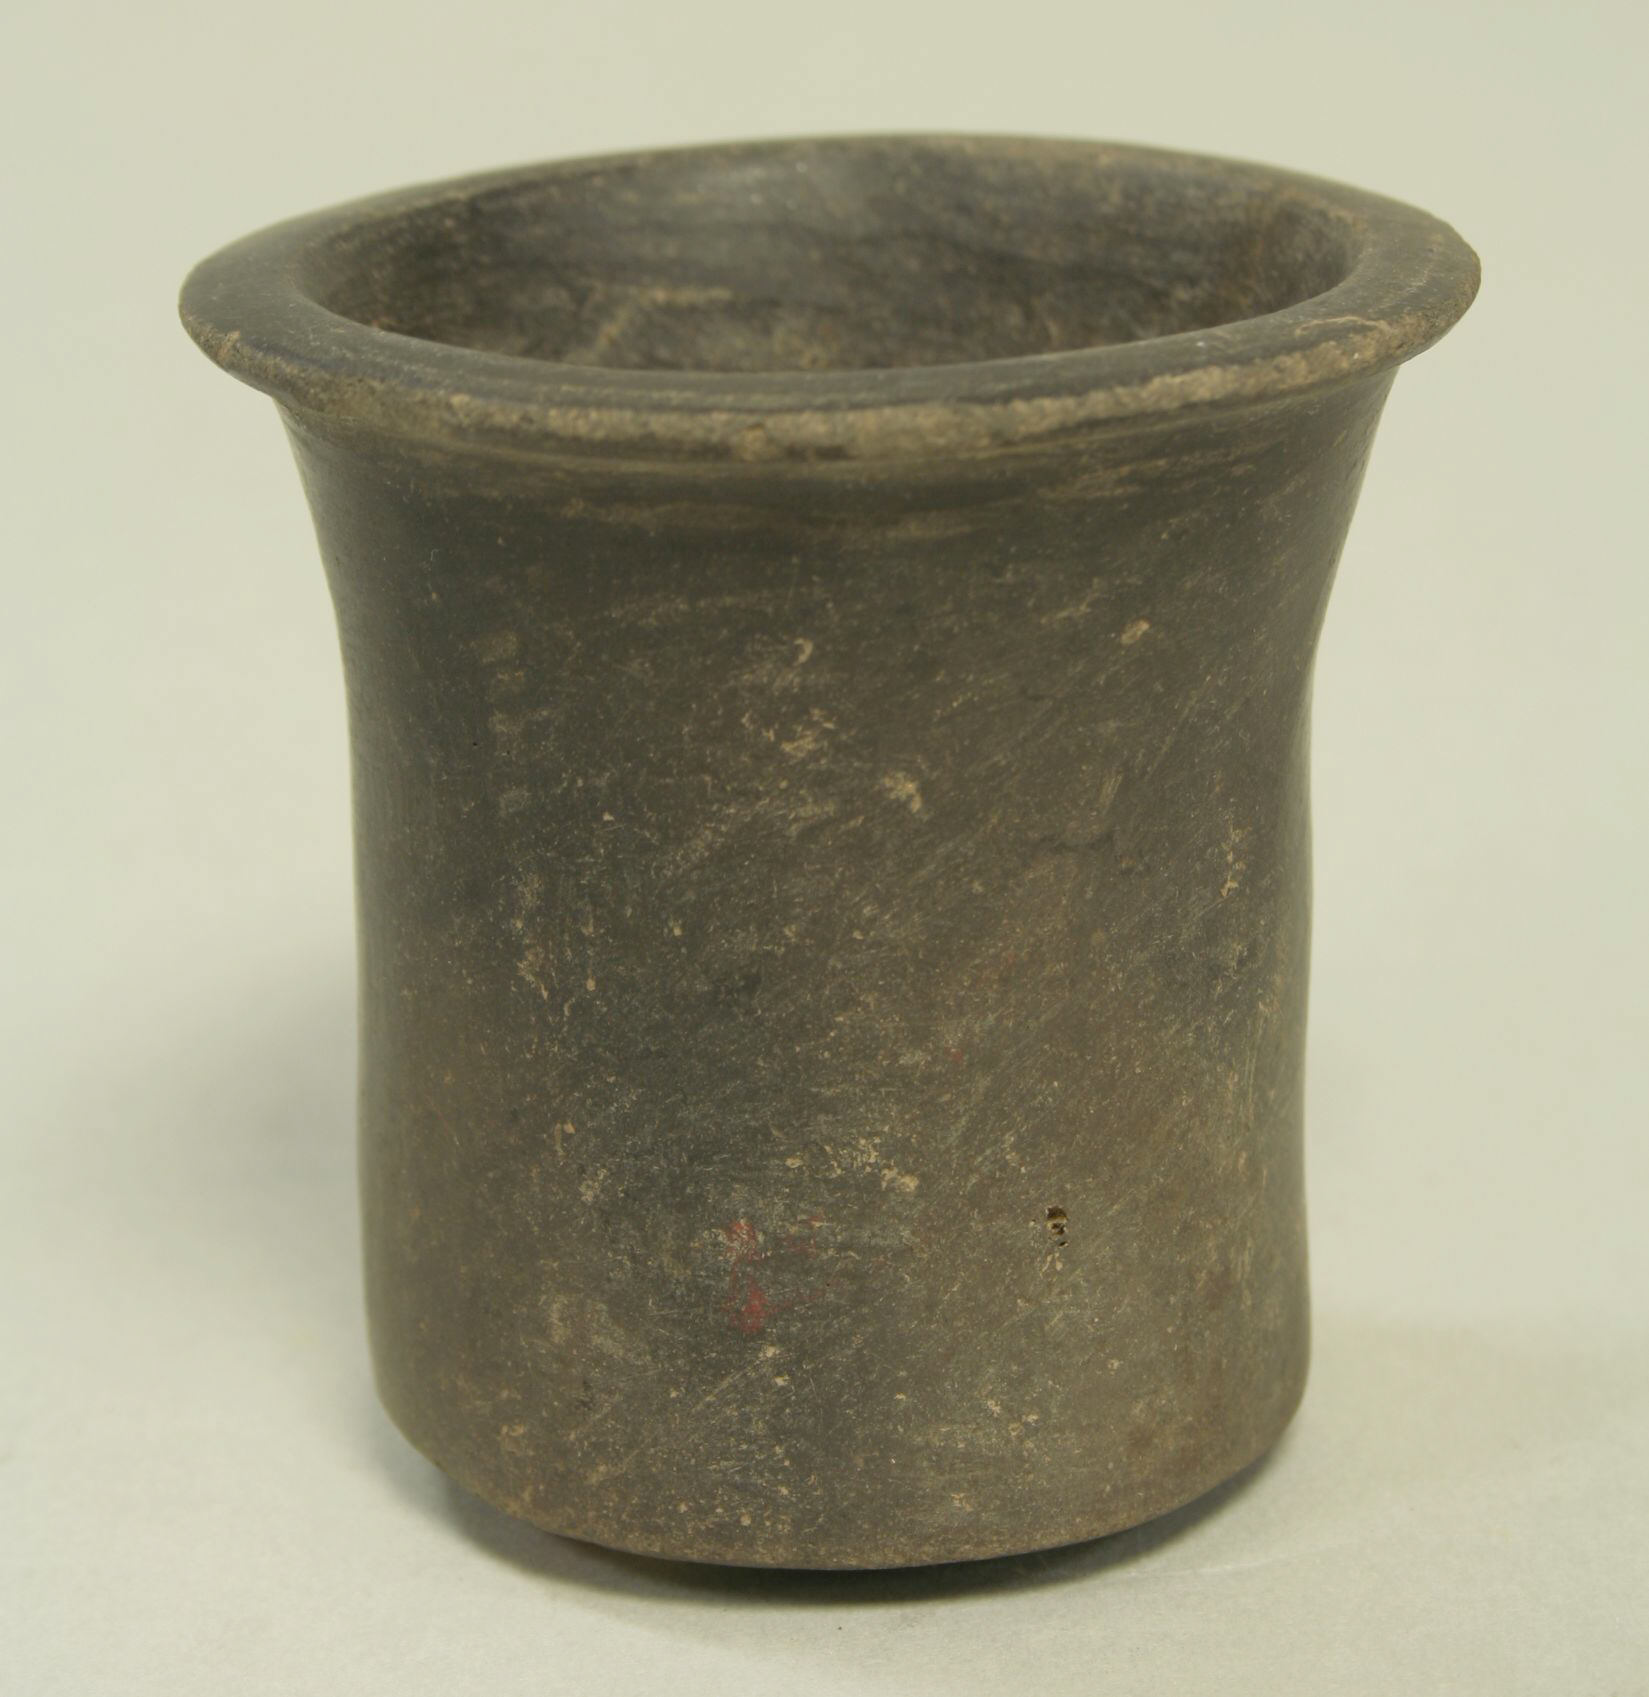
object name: cup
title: Tall Plain Cup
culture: paracas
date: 500-101 BCE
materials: ceramic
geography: peru